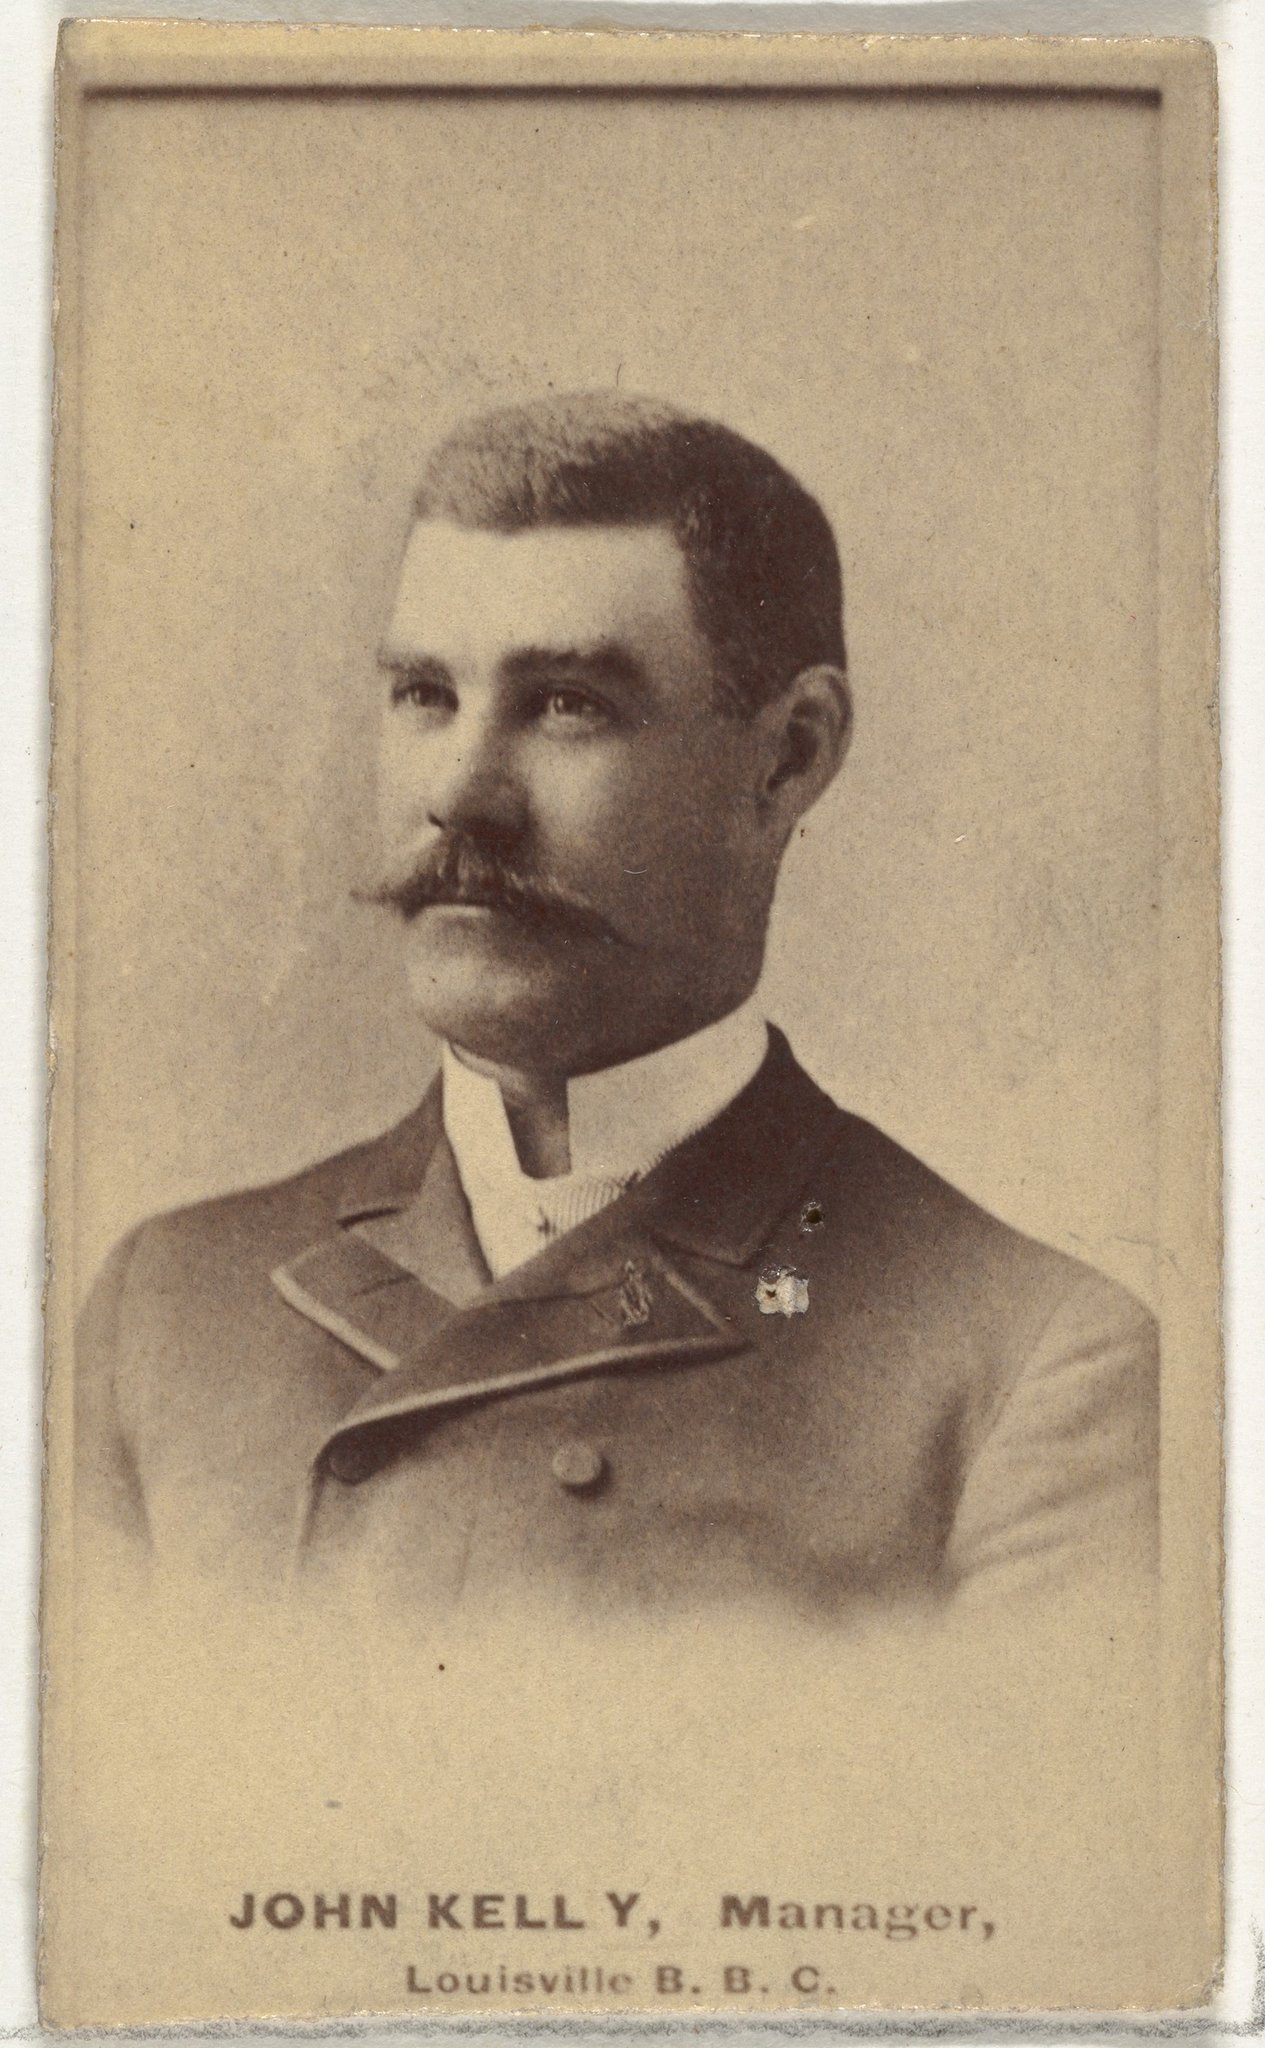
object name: baseball card, photograph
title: John O. "Kick" Kelly, Manager, Louisville Colonels, from the Old Judge series (N172) for Old Judge Cigarettes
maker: goodwin & company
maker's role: publisher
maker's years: 1850-1950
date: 1887-1890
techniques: albumen silver print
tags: men,portraits